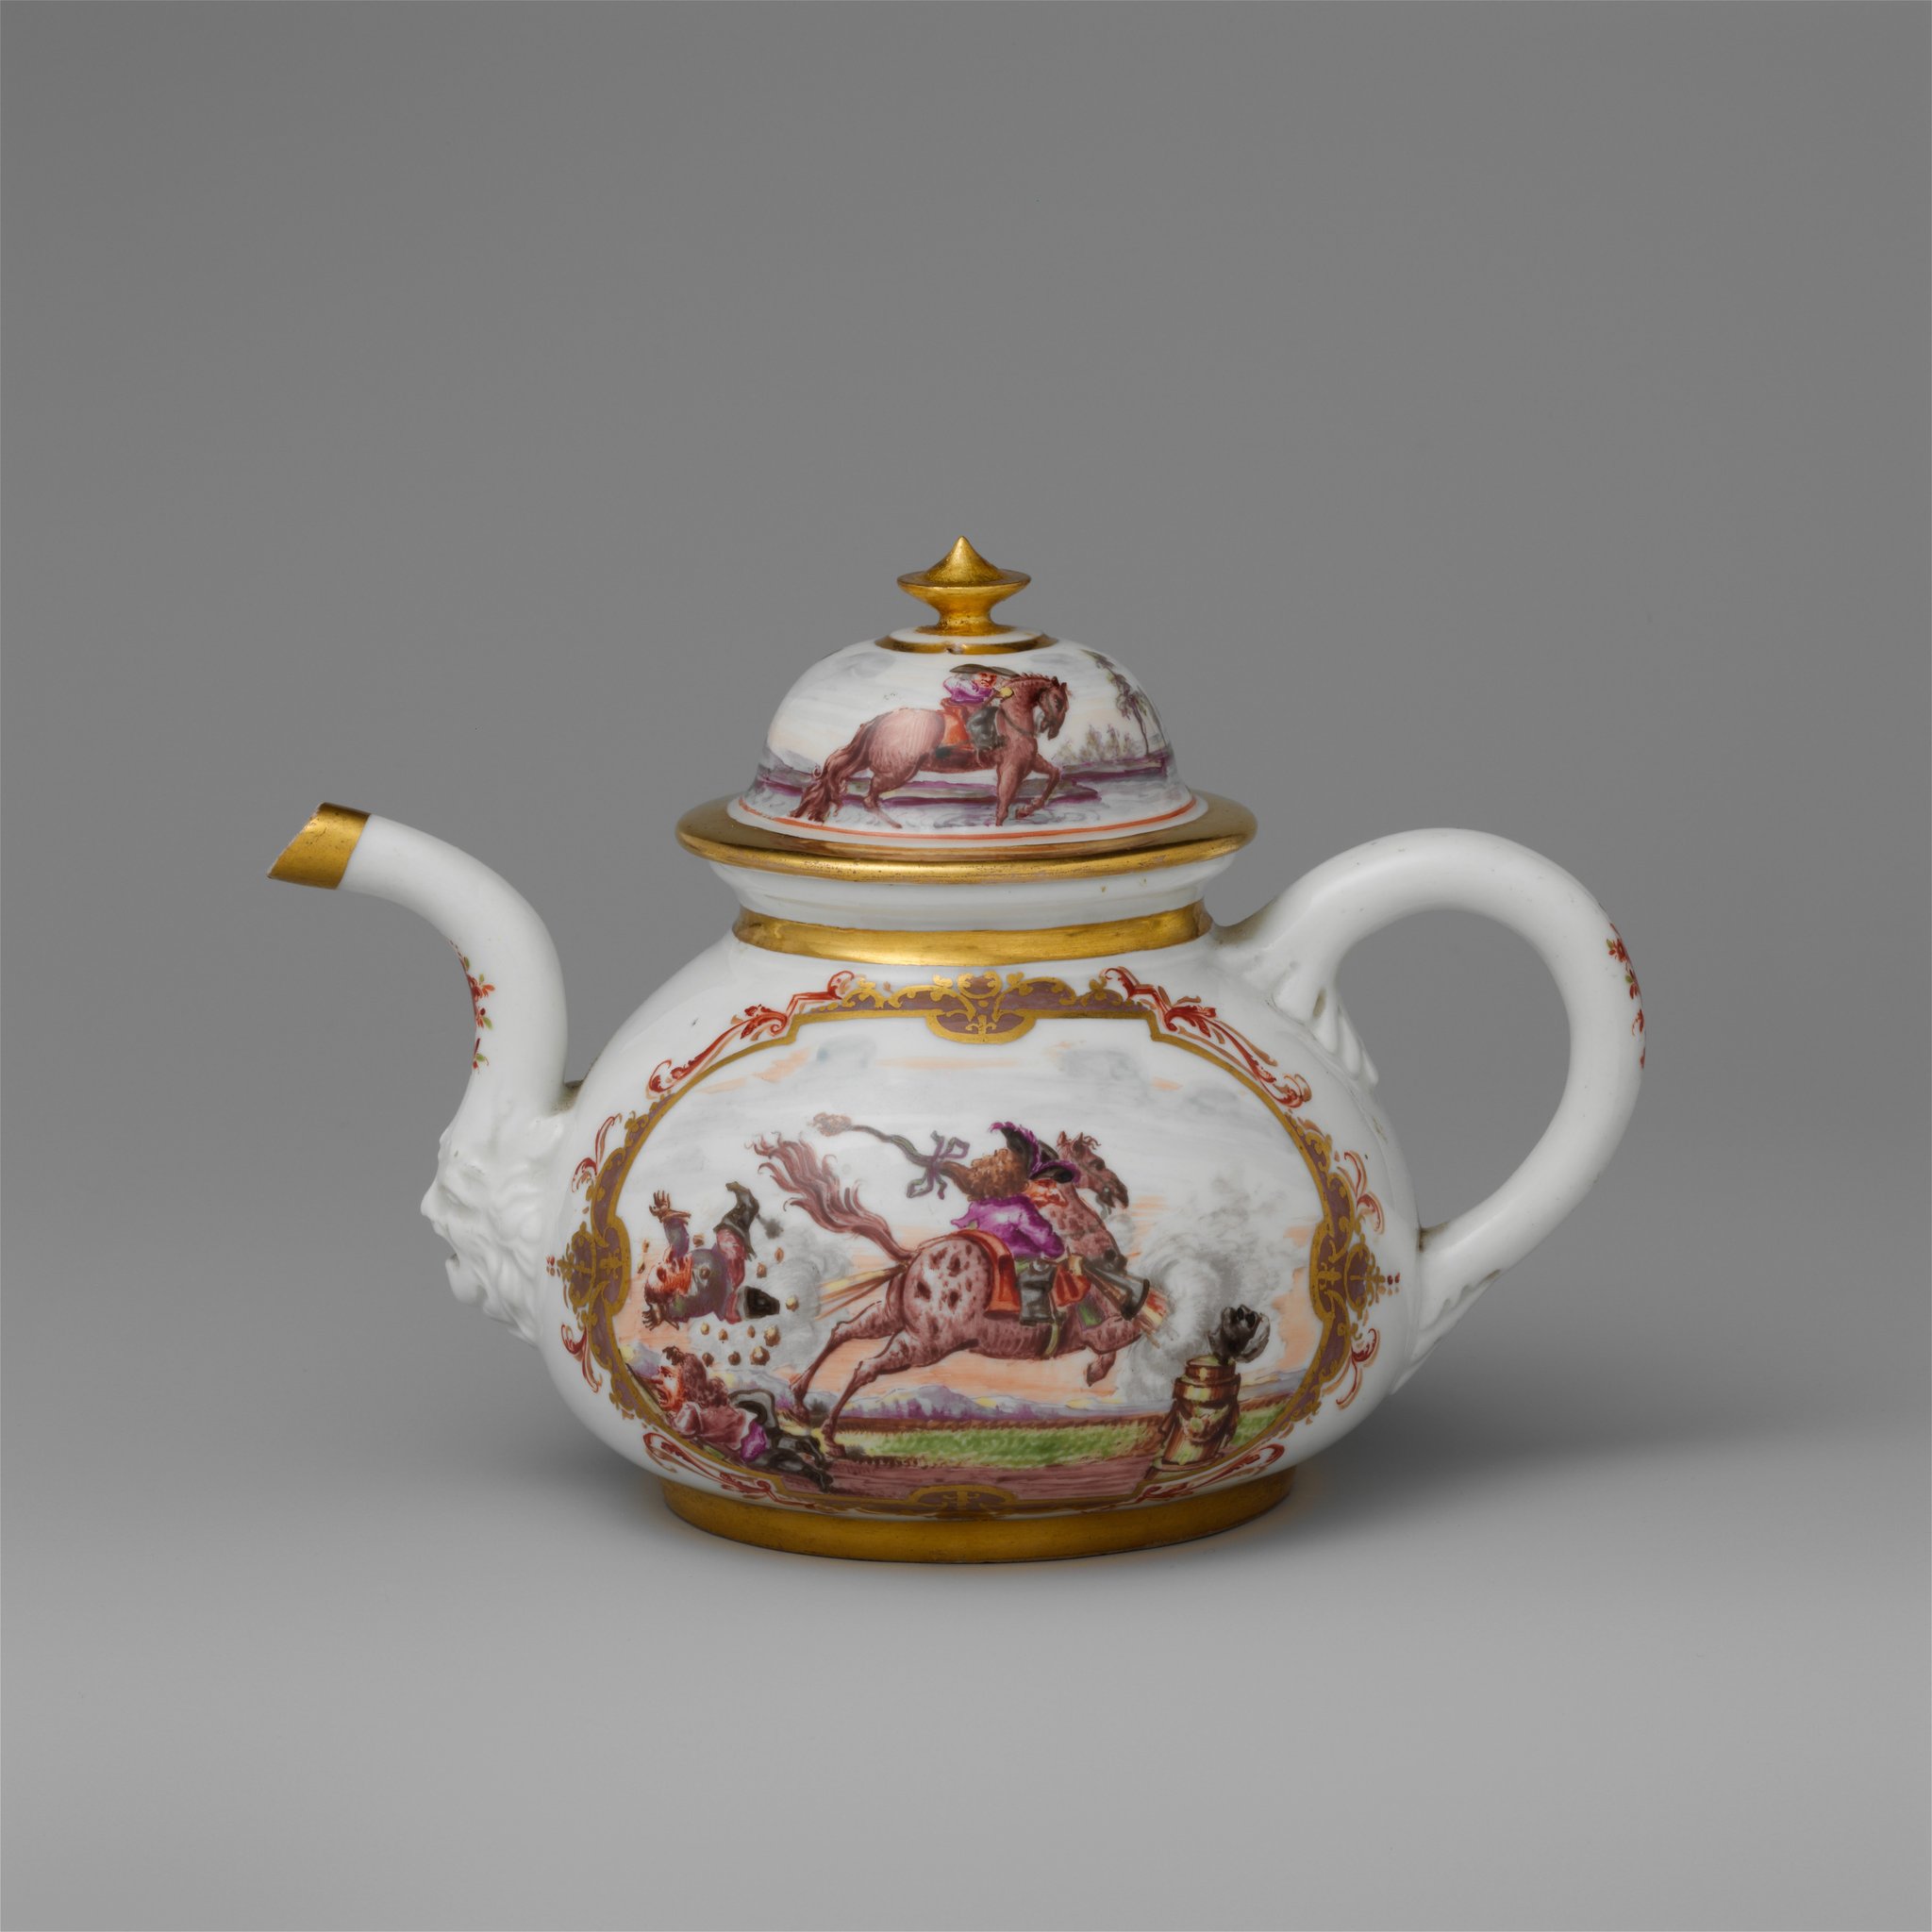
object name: teapot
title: Teapot with equestrian scene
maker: meissen manufactory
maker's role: manufactory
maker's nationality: german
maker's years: 1710-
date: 1722-1723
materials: enamel, gold, hard paste porcelain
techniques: polychrome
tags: horses